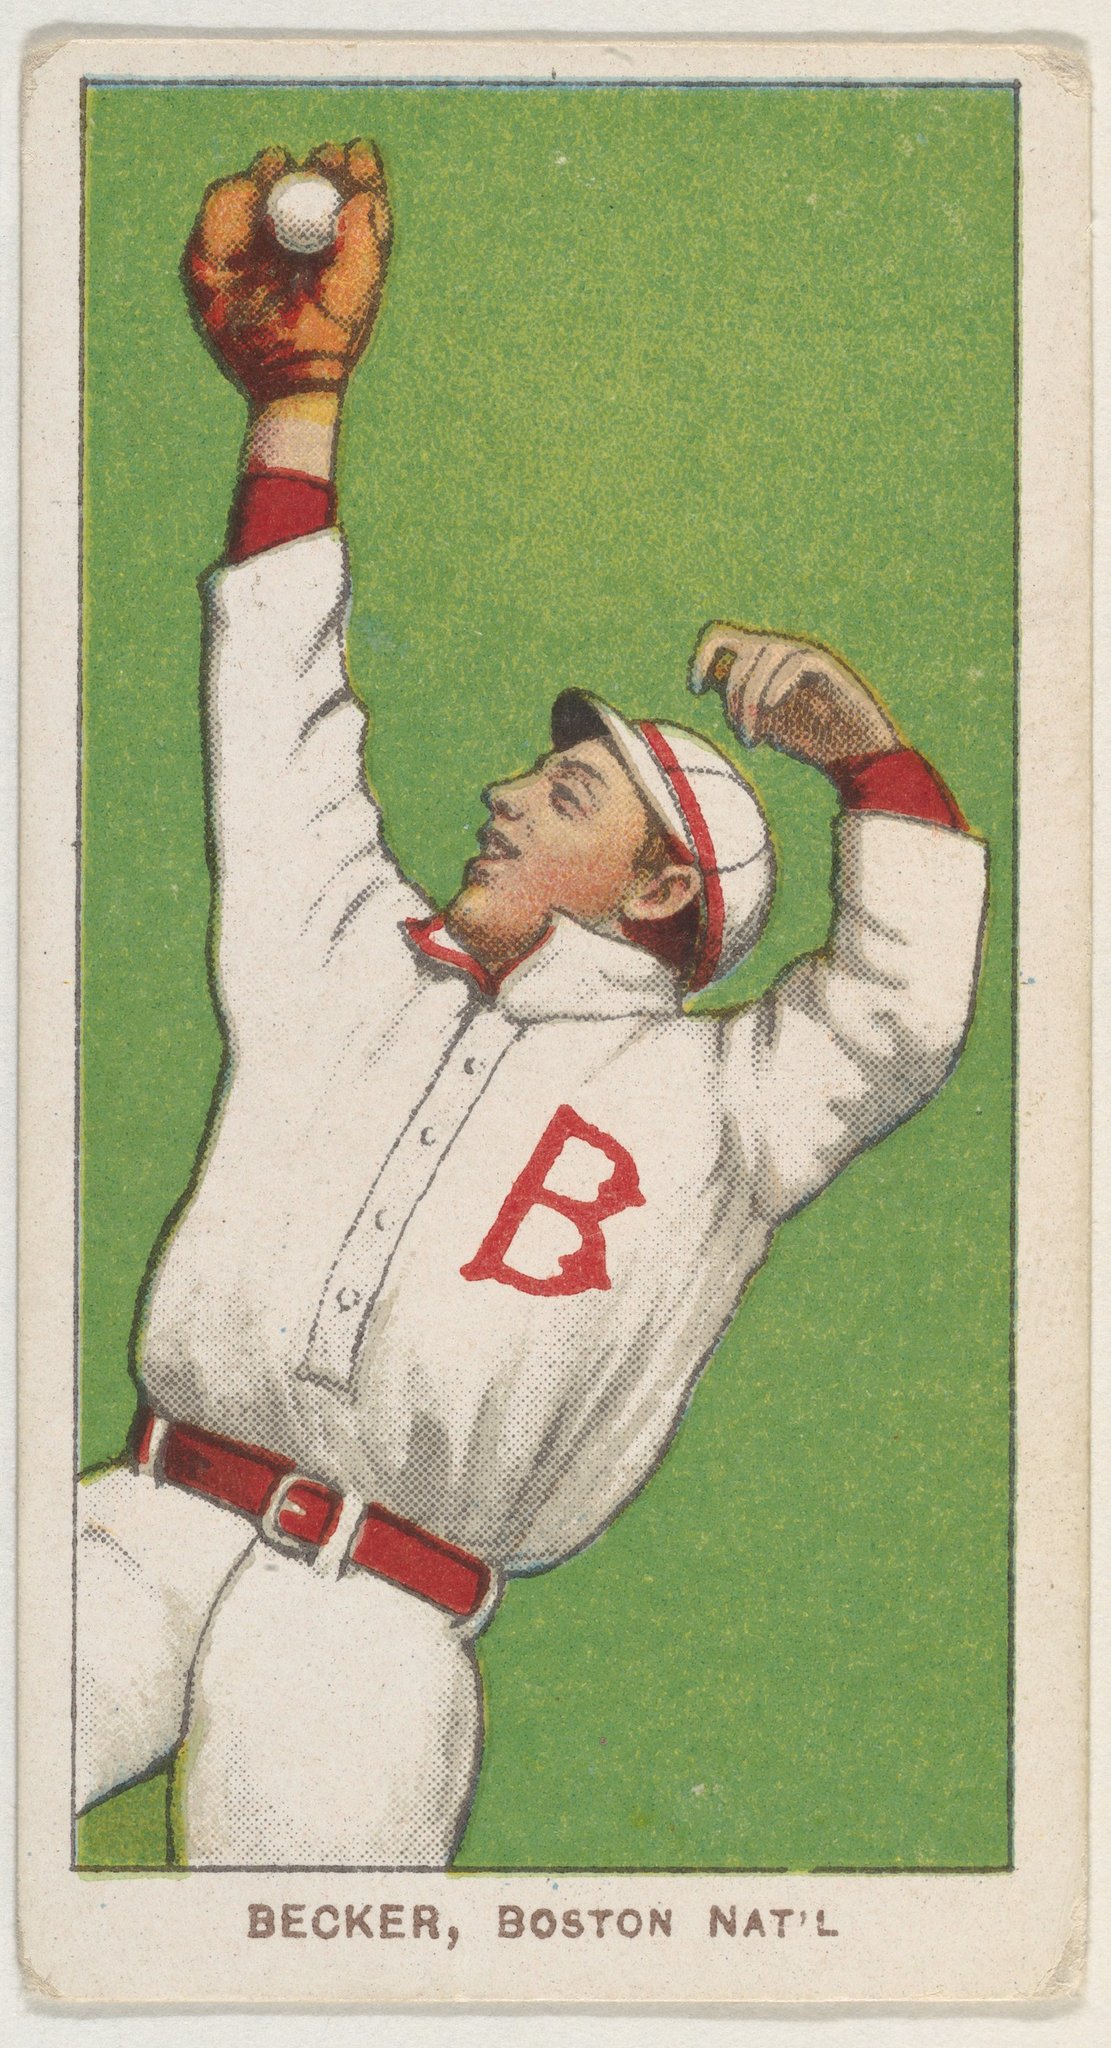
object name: baseball card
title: Becker, Boston, National League, from the White Border series (T206) for the American Tobacco Company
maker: american tobacco company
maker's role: publisher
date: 1909-1911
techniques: lithography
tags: men,baseball,athletes